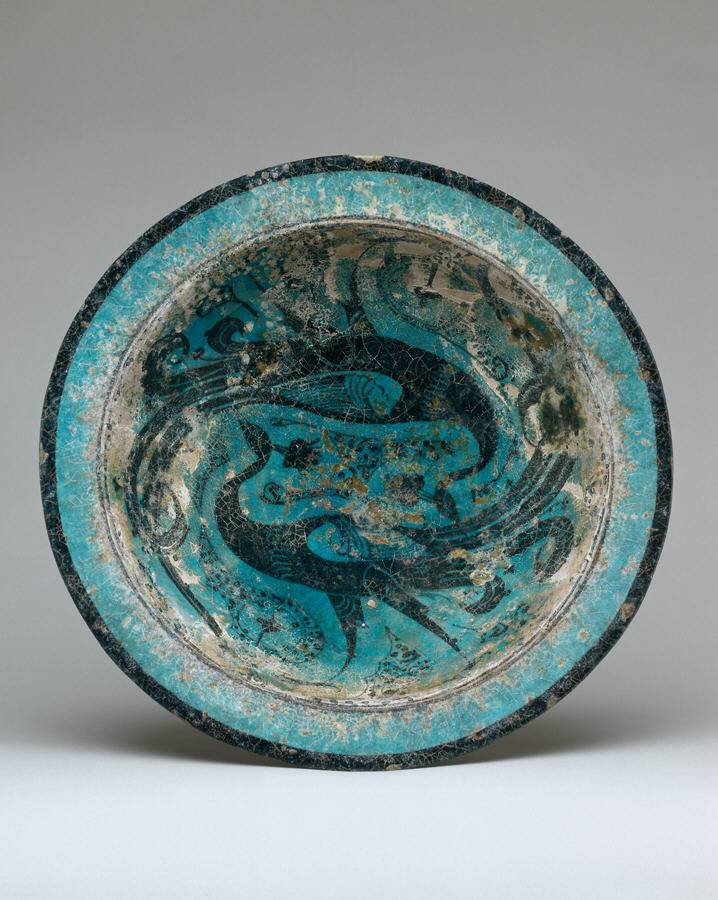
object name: bowl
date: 1167-1233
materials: stonepaste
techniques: incising, painting, underglaze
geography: syria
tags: peacocks